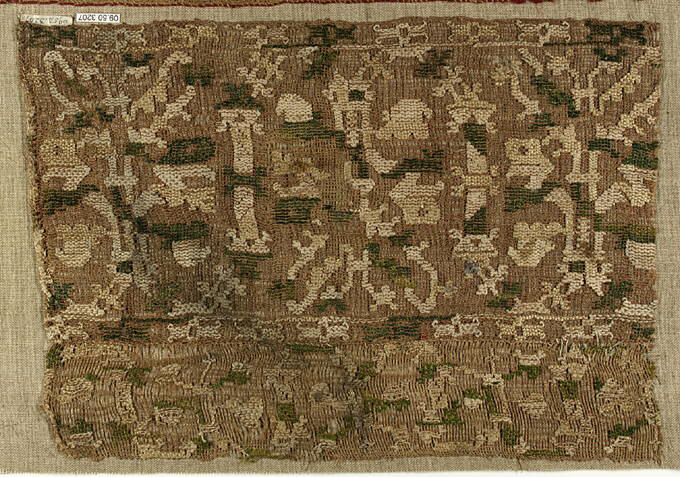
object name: fragment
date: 1601-1700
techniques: embroidery